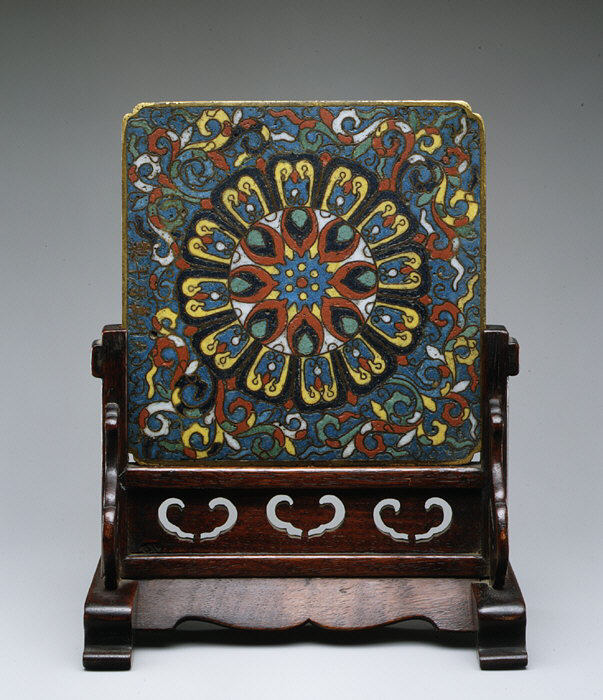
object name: plaque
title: Desk Screen with Stylized Floral Design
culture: chinese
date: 1567-1633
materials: enamel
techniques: enamel